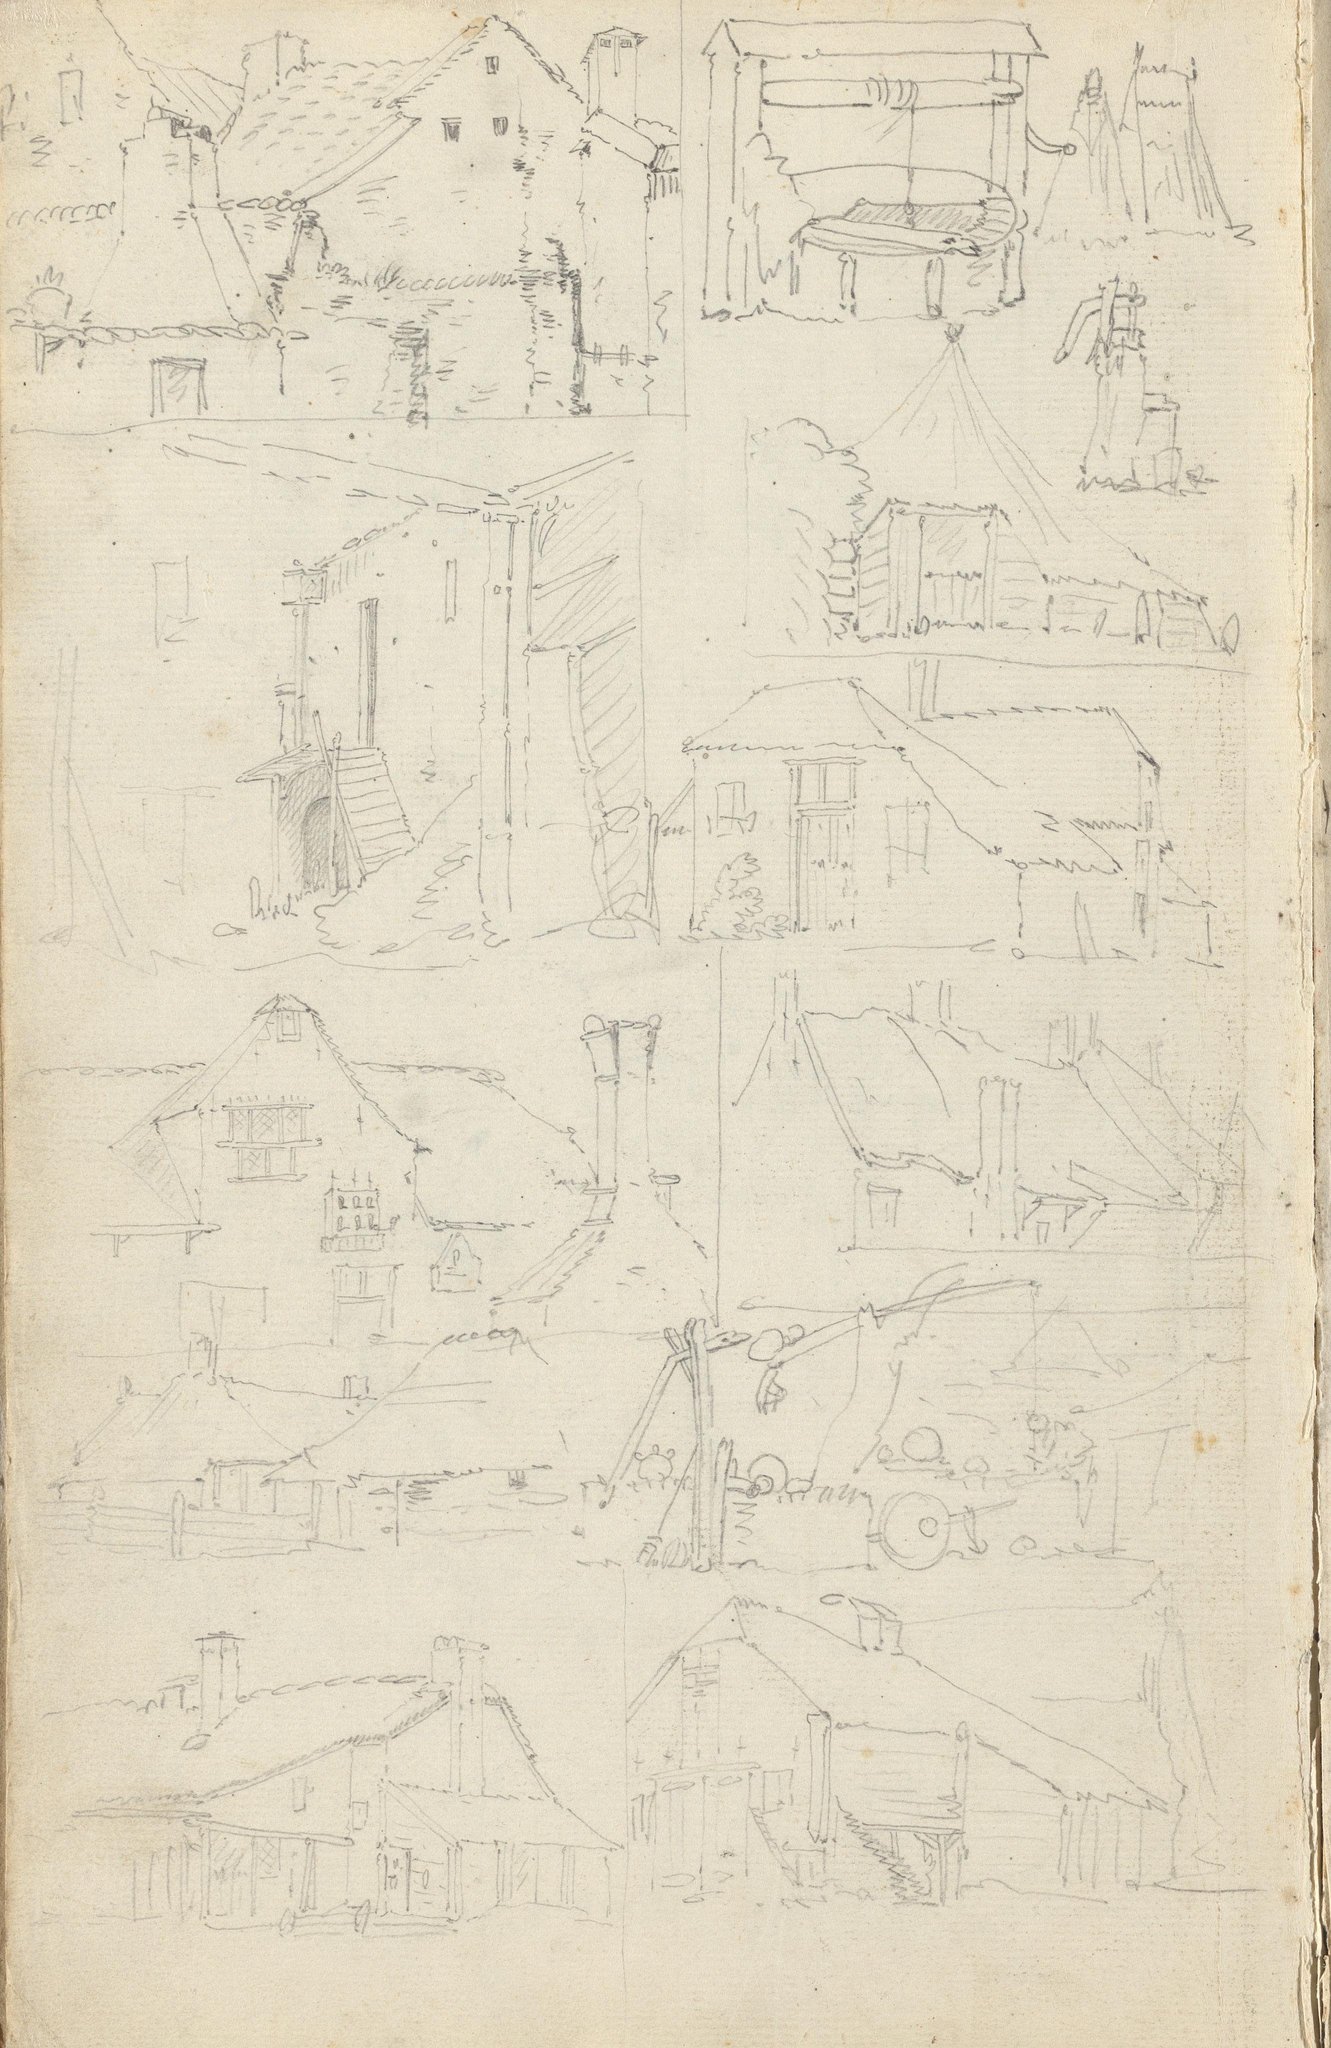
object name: sketchbook leaf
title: Boerderijen en een waterput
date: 1780-1800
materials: paper, pencil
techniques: drawing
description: Blad 14 verso uit een schetsboek met 17 bladen.